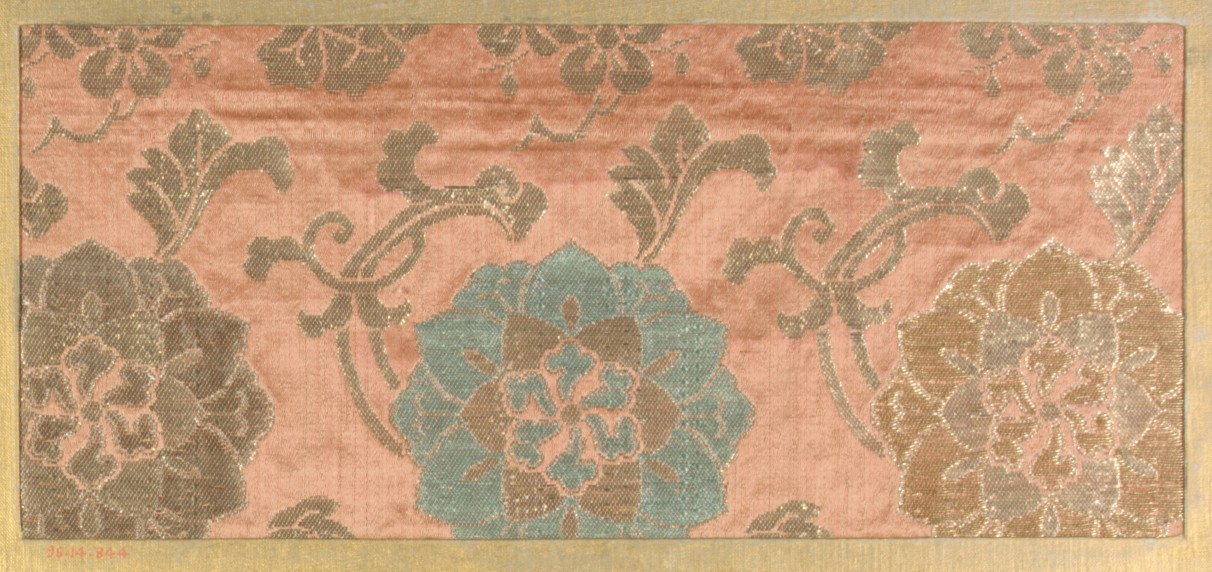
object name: piece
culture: japanese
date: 1701-1900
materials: silk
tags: flowers